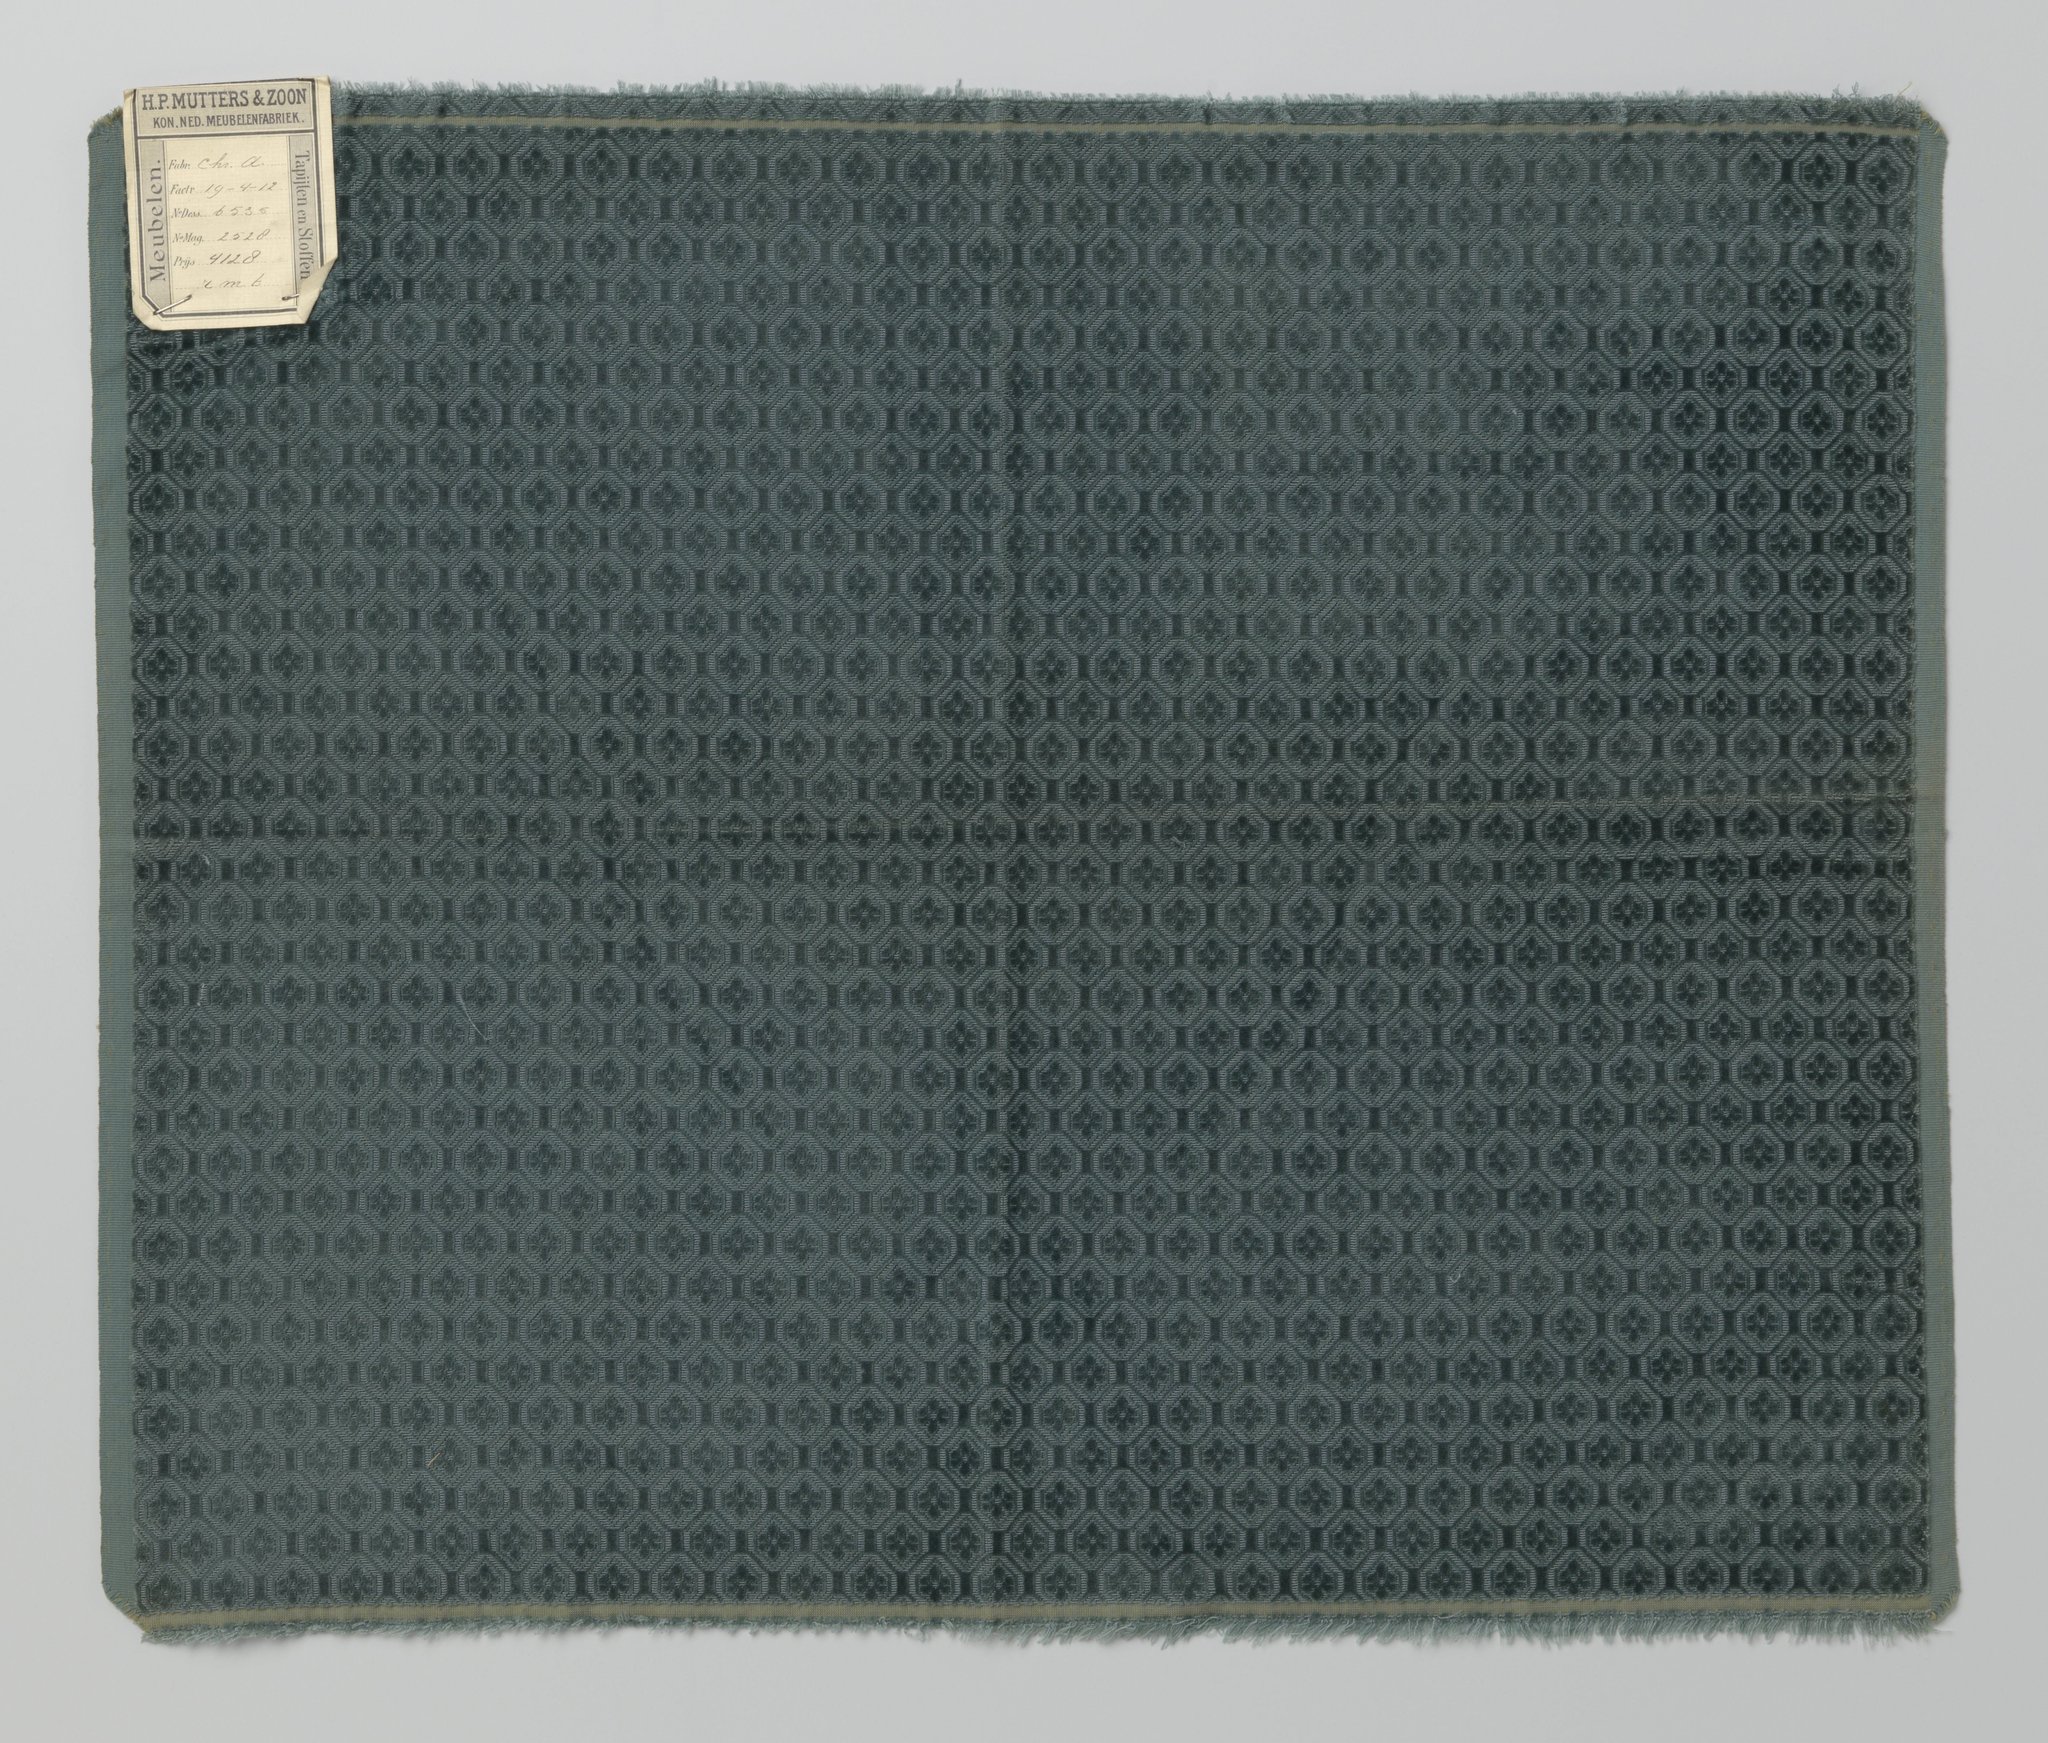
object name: bekledingsstof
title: Genopte en gesneden fluweel met geometrisch patroon van zeshoeken, met gestileerde bloem, in groenig blauw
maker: a. chrobolka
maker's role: kleermaker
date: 1912-1915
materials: silk, velvet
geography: netherlands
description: Bekledings- of bespanningsstof van genopte en gesneden fluweel met geometrisch patroon van zeshoeken, met gestileerde bloem, in groenig blauw.